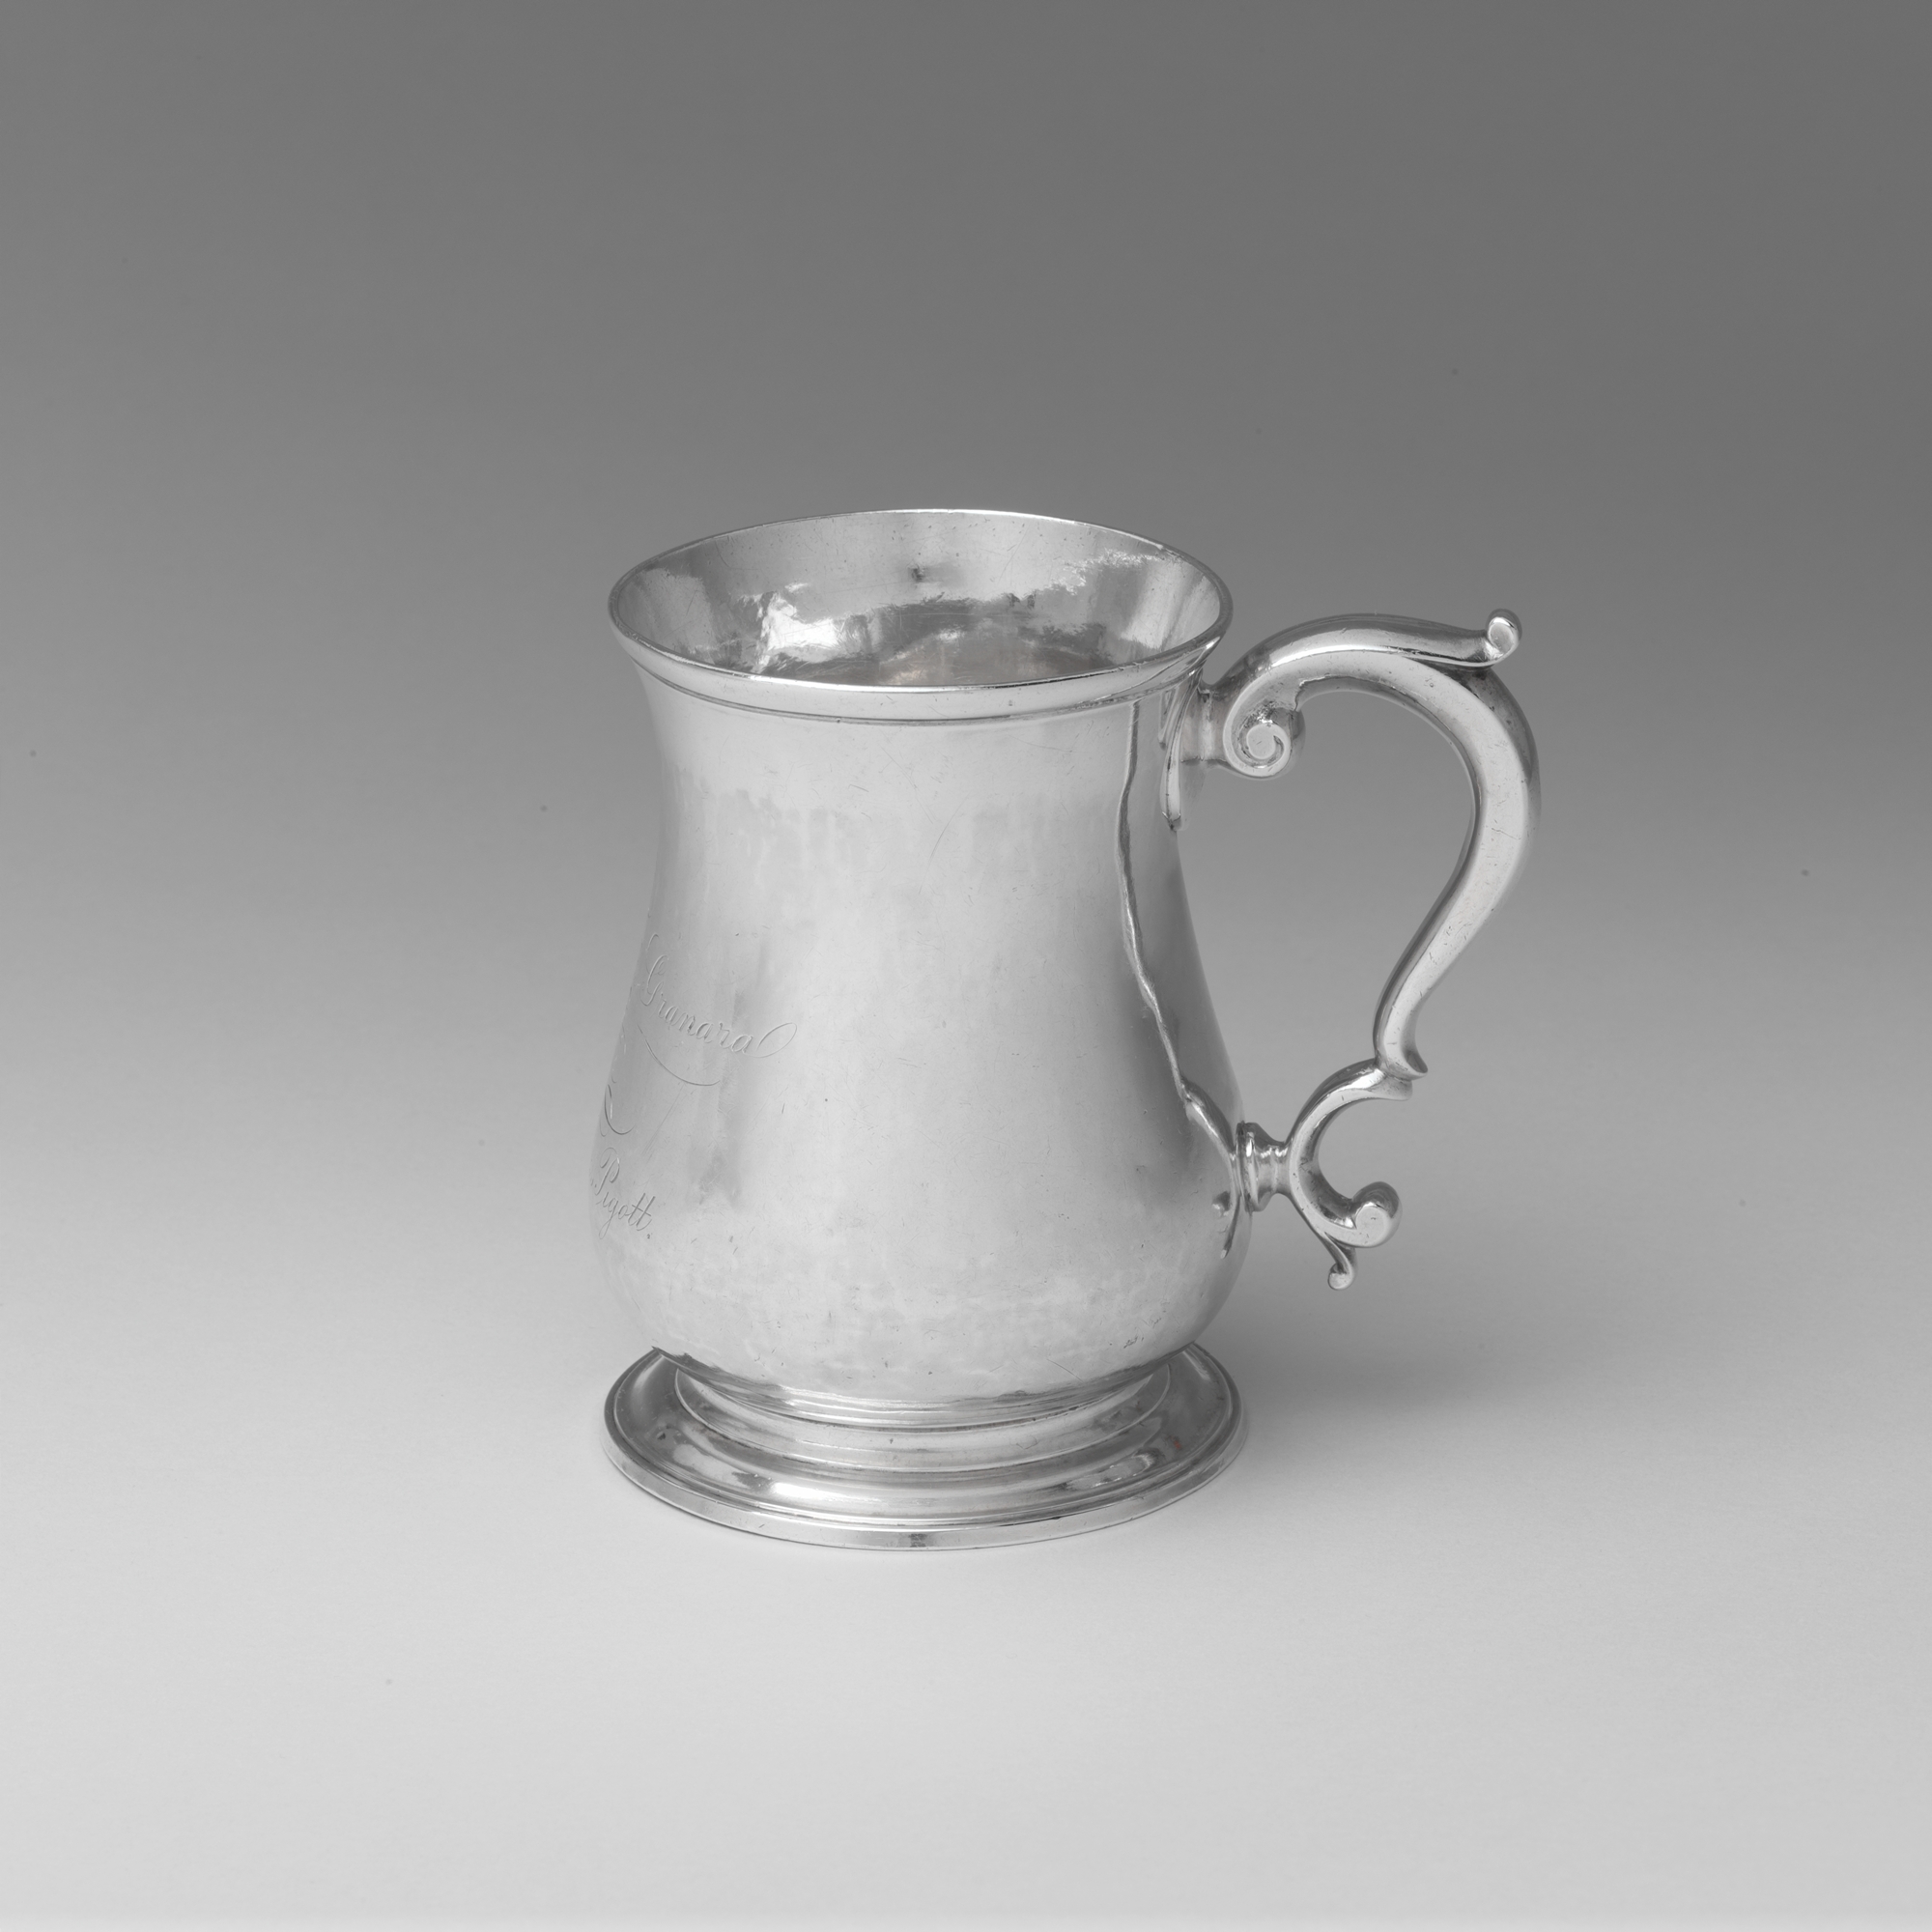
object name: cann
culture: american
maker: george hanners jr.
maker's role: maker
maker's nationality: american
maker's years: 1721-1760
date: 1750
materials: silver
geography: united states